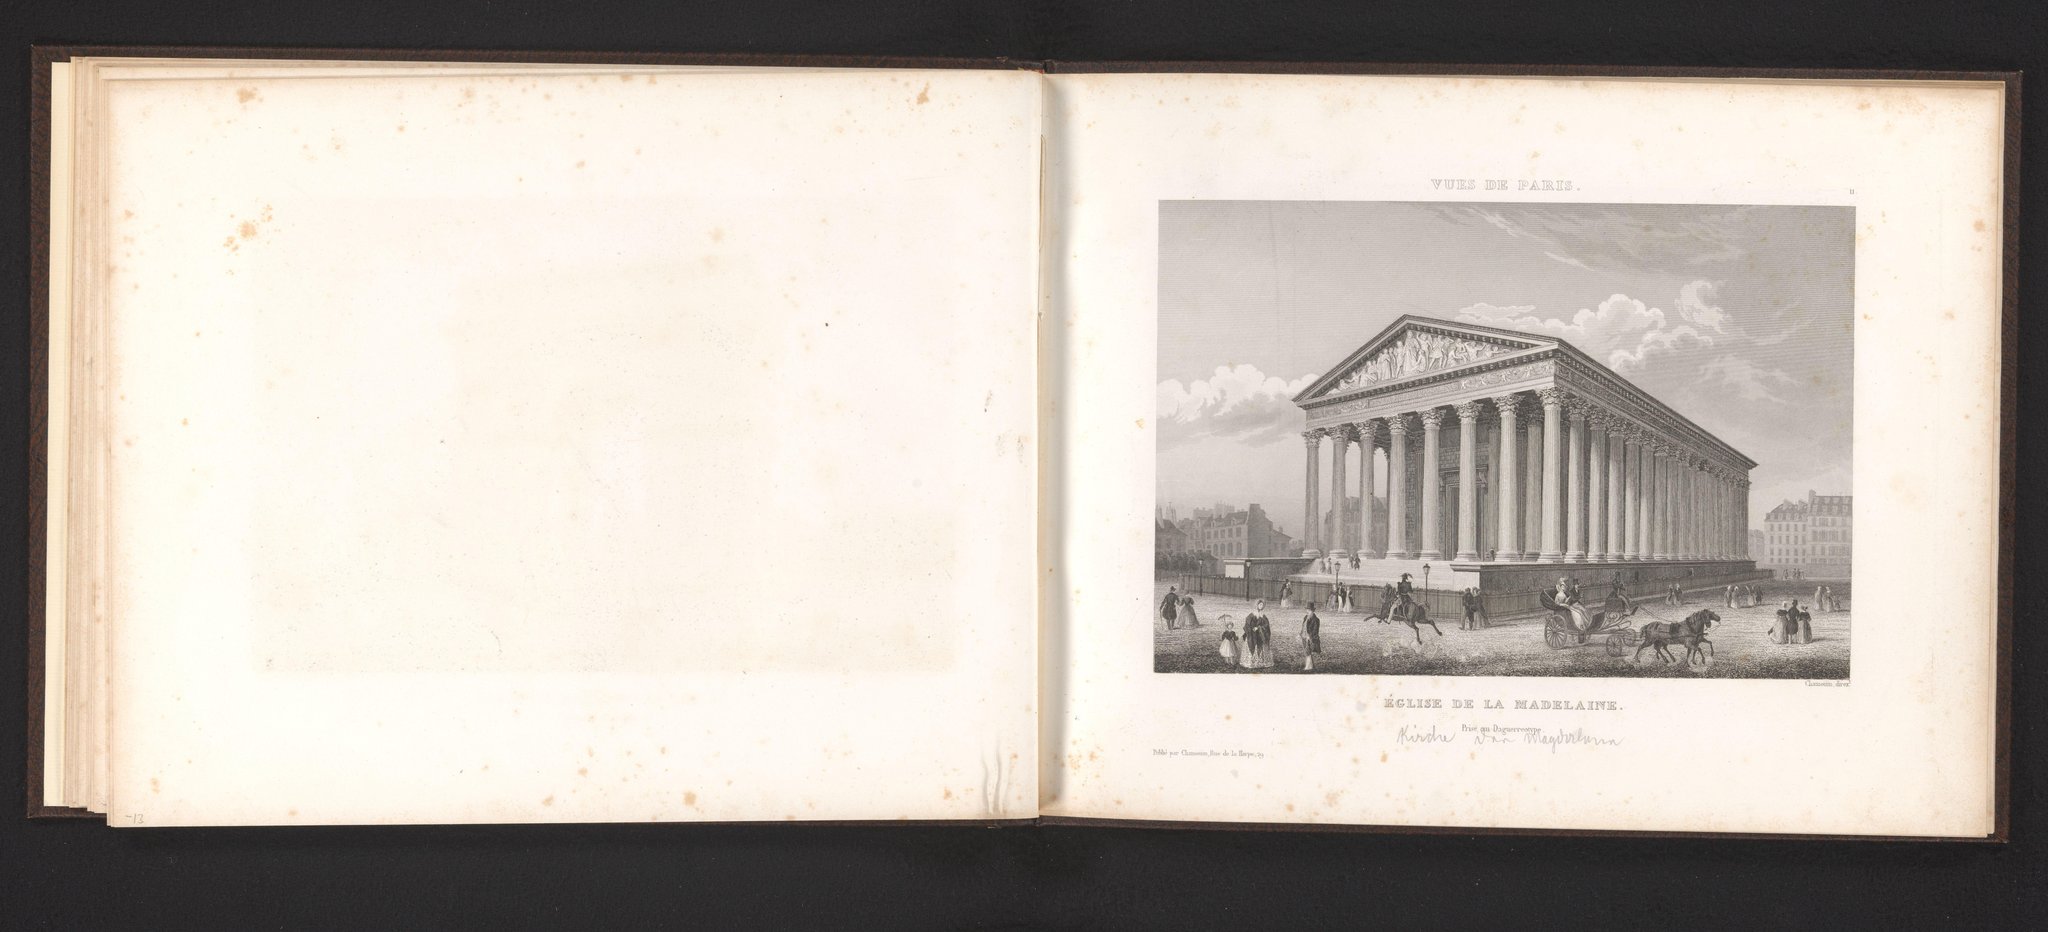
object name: print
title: Église de la Madeleine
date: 1845-1850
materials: paper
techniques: engraving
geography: paris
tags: church (exterior)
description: Prent op veertiende ongenummerde pagina na titelpagina. Prent gemaakt naar daguerreotypie.